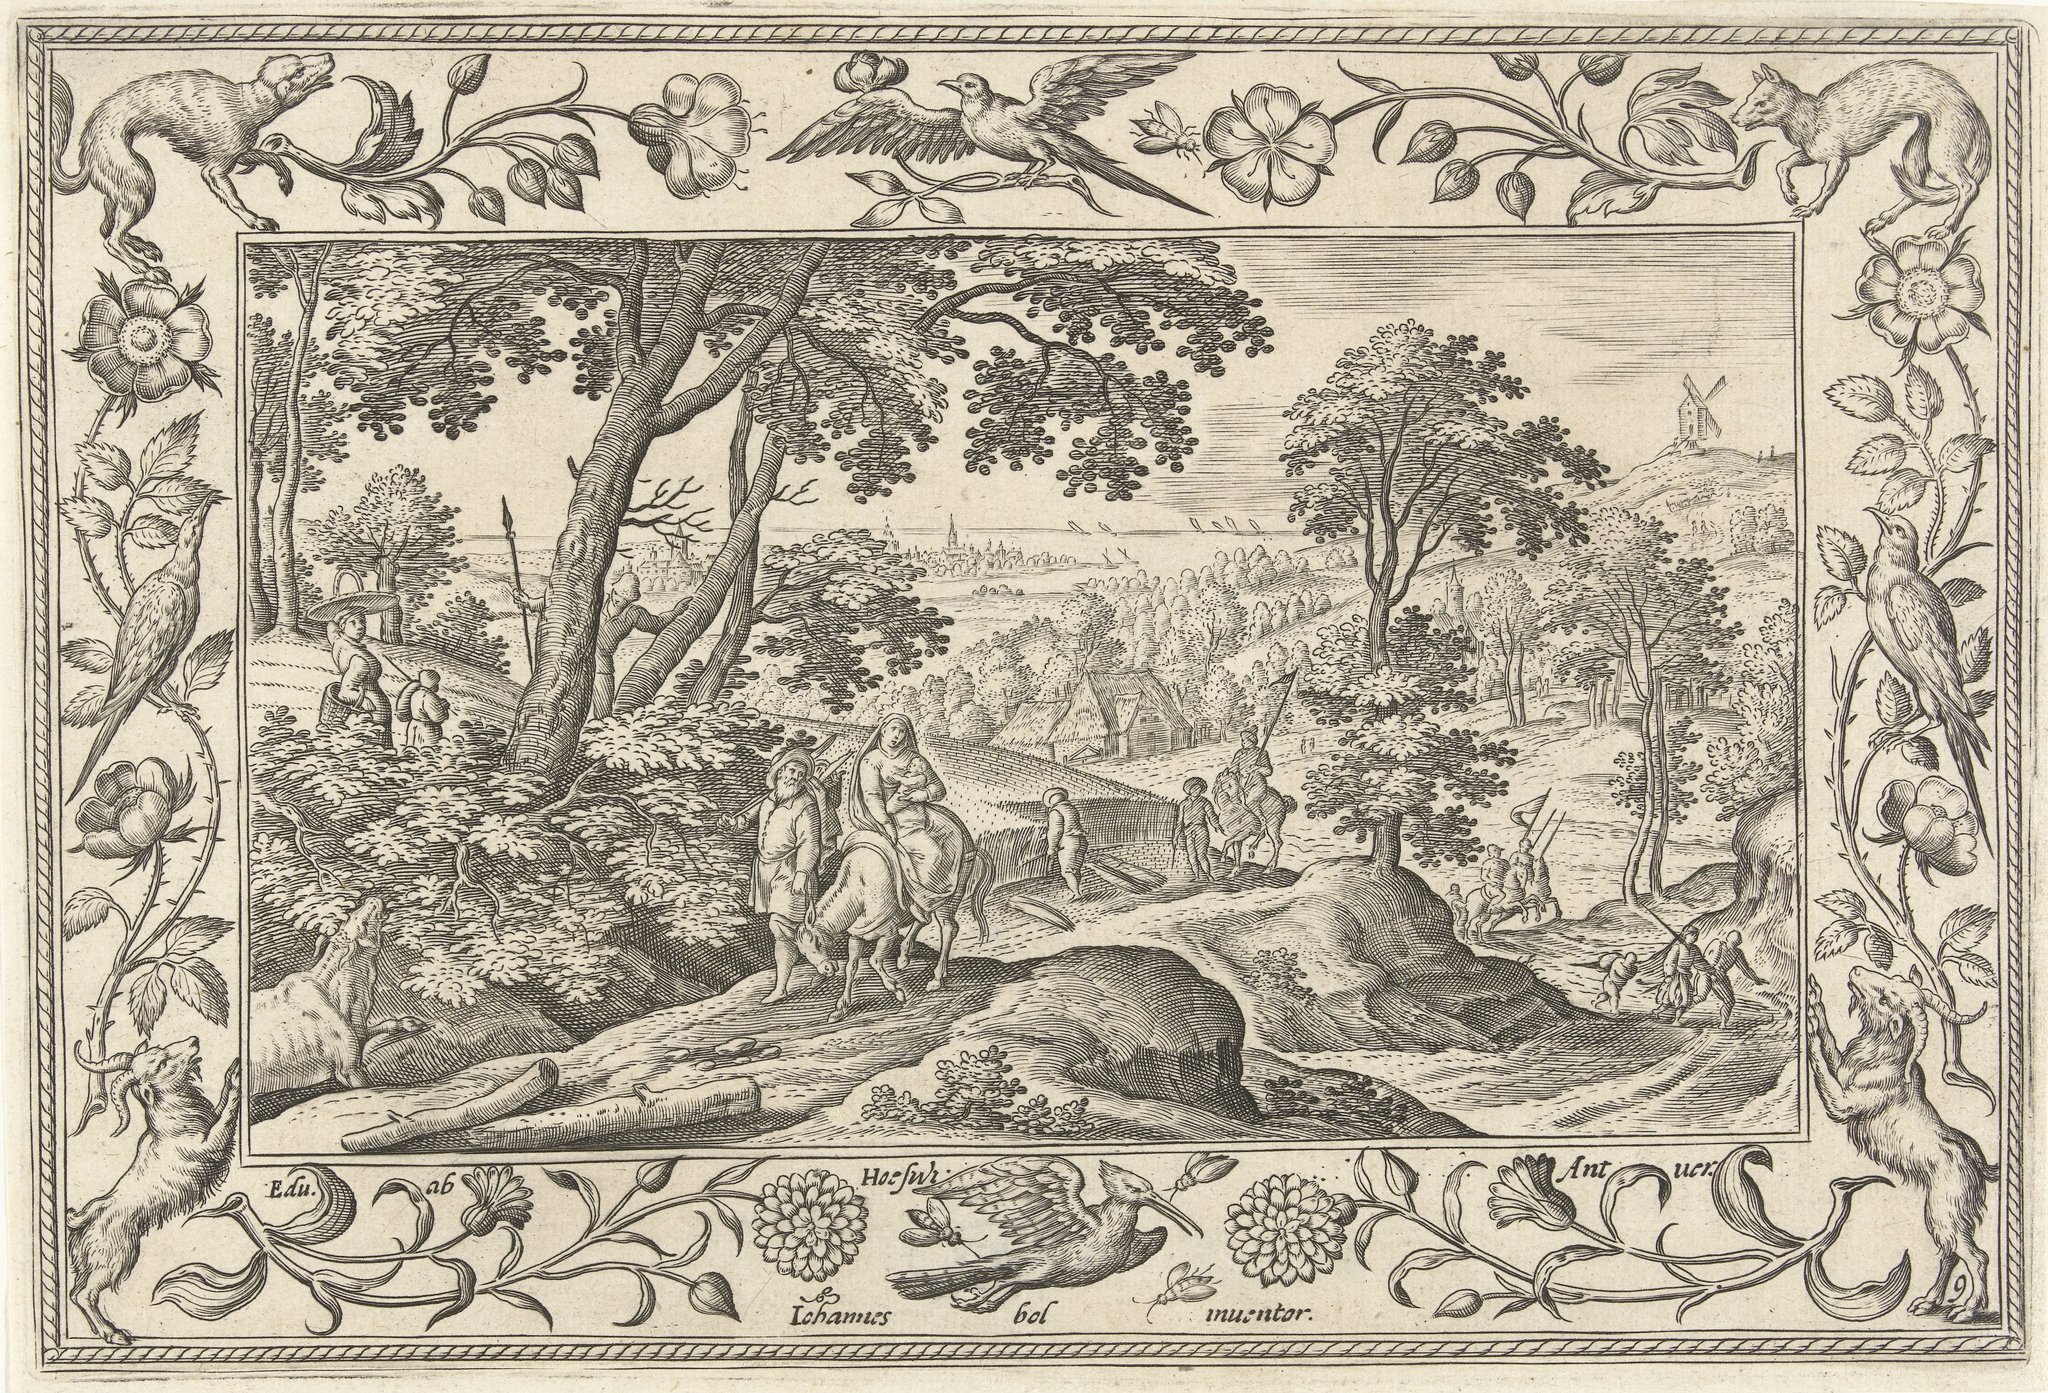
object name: print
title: Vlucht naar Egypte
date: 1582-1586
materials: paper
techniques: engraving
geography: antwerp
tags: dale, valley, ornamental birds, flight into egypt and miracles during the journey, beasts of prey, predatory animals: weasel (+ ornamental variants of animals), he-goat, billy-goat (+ animals used symbolically), flowers ~ ornament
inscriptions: collector's mark: Lugt 2228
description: Heuvenlandschap. Op de voorgrond Jozef met Maria en kind op een ezel. Ze zijn op de vlucht voor de soldaten van Herodes. De prent heeft een ornamentlijst met bloemen en dieren. Hij maakt deel uit van een vierentwintigdelige serie van landschappen met Bijbelse, mythologische scènes en jachttaferelen.